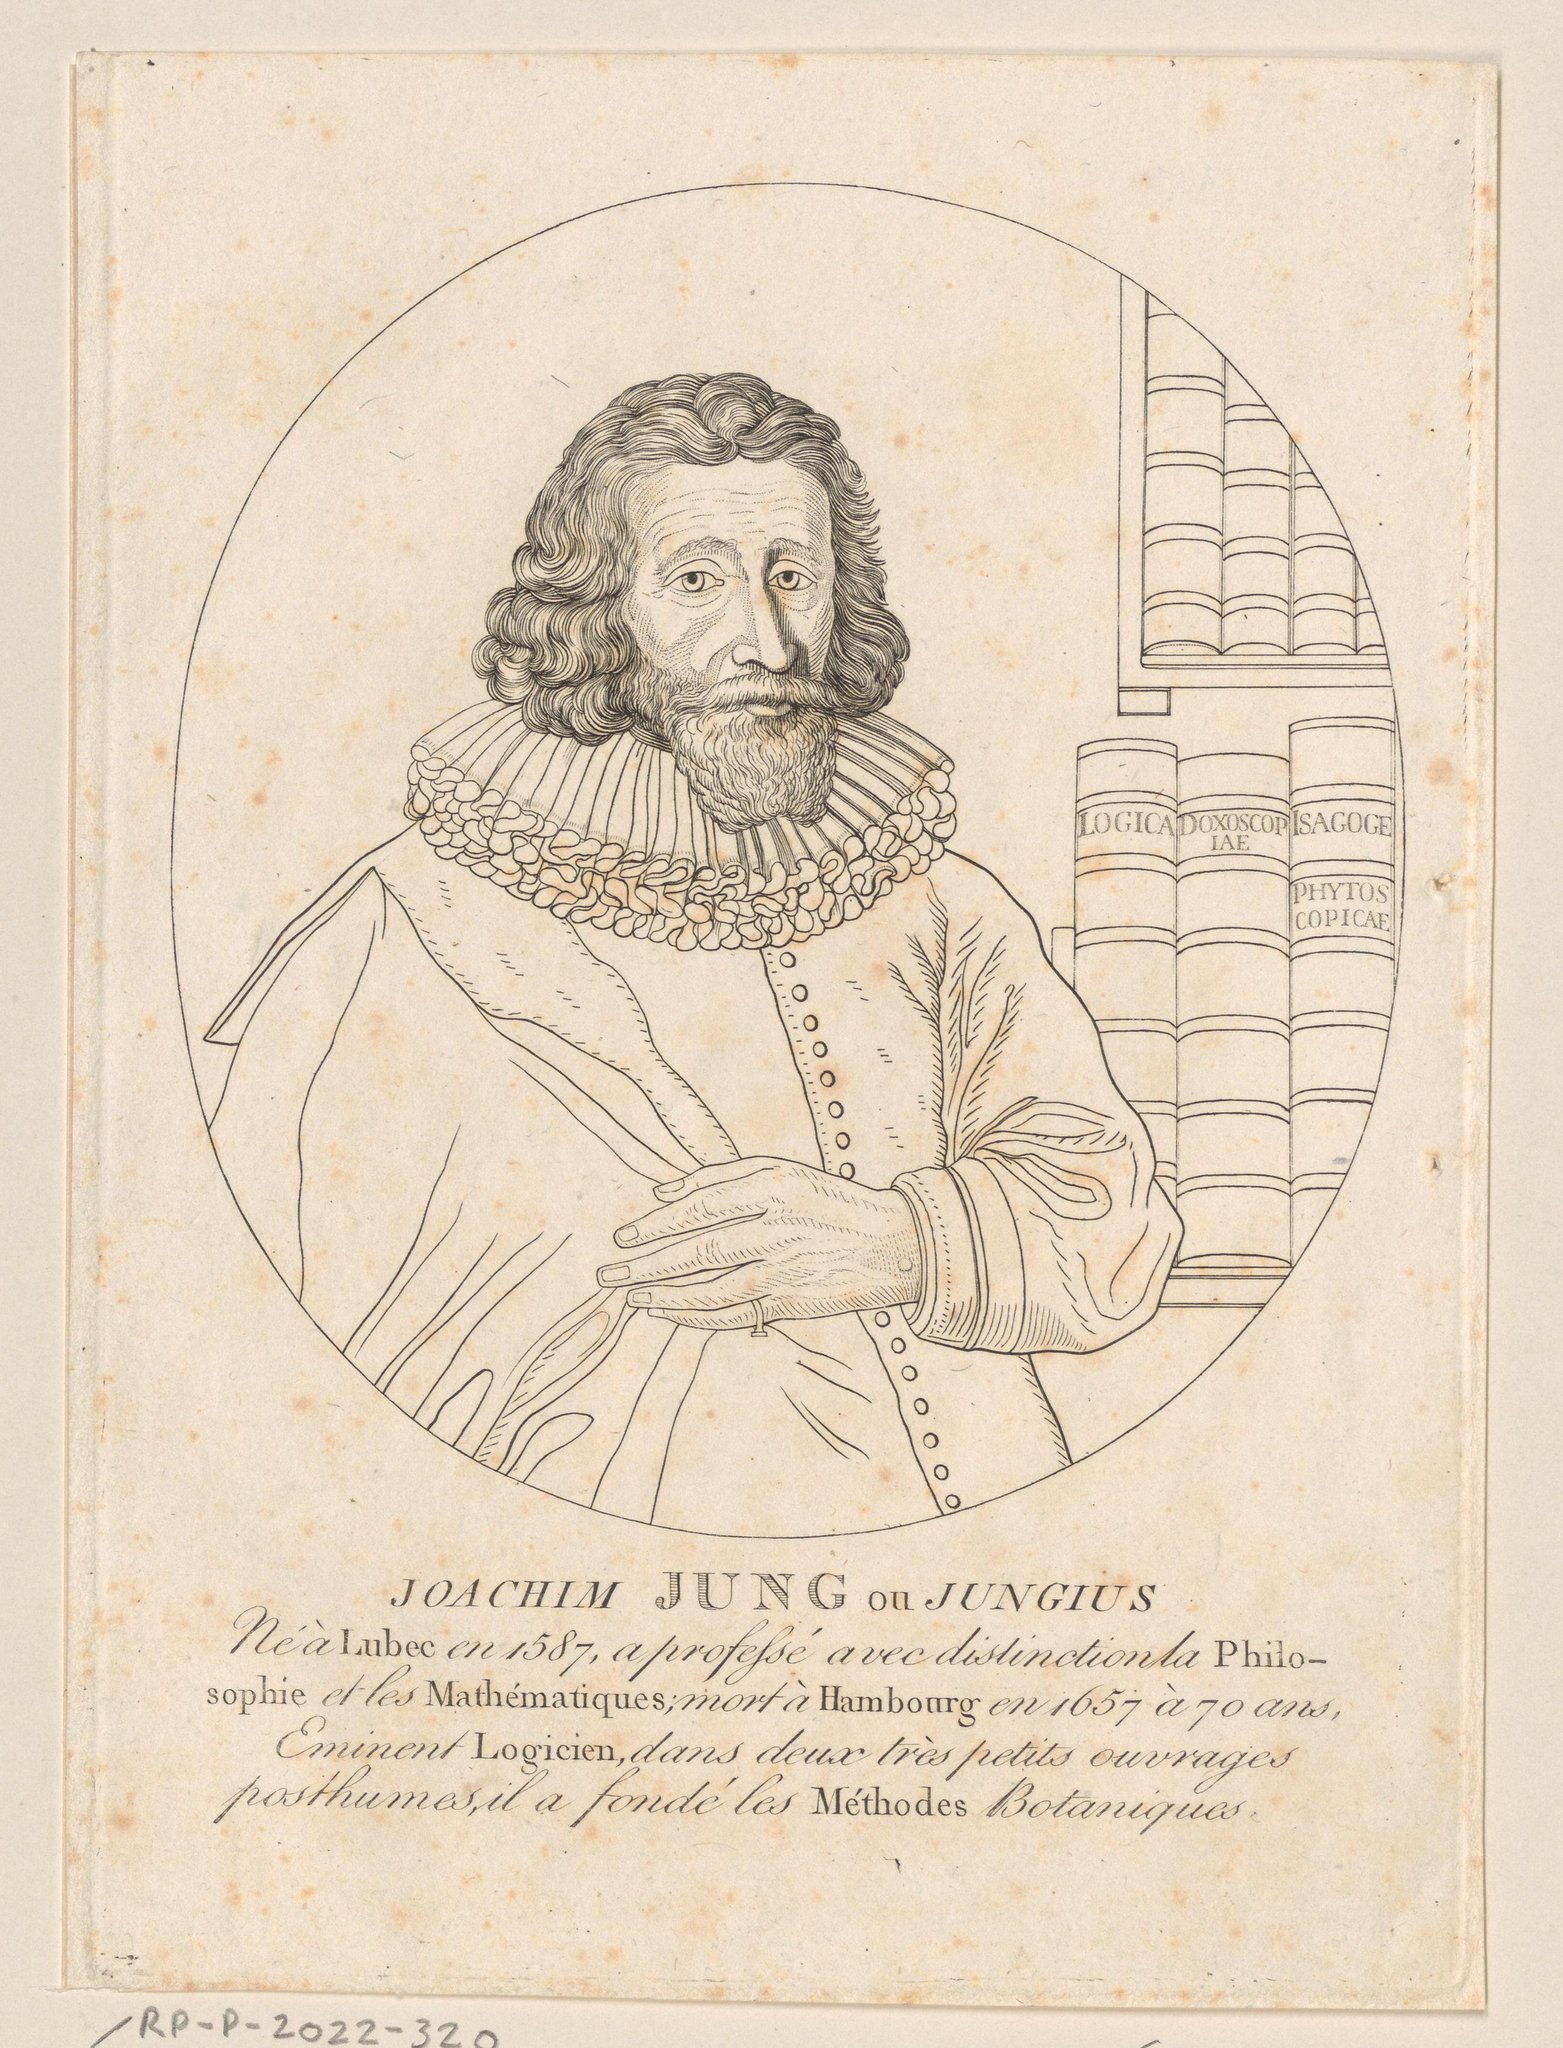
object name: print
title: Portret van Joachim Jungius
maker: Anonymous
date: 1819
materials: paper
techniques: etching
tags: scholar, philosopher, historical persons, mathematics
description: Prent waarschijnlijk uit: Aubert-Aubert du Petit-Thouars, Louis Marie. Cours de phytologie ou de botanique générale (...). Parijs: Pierre Gueffier, 1819.